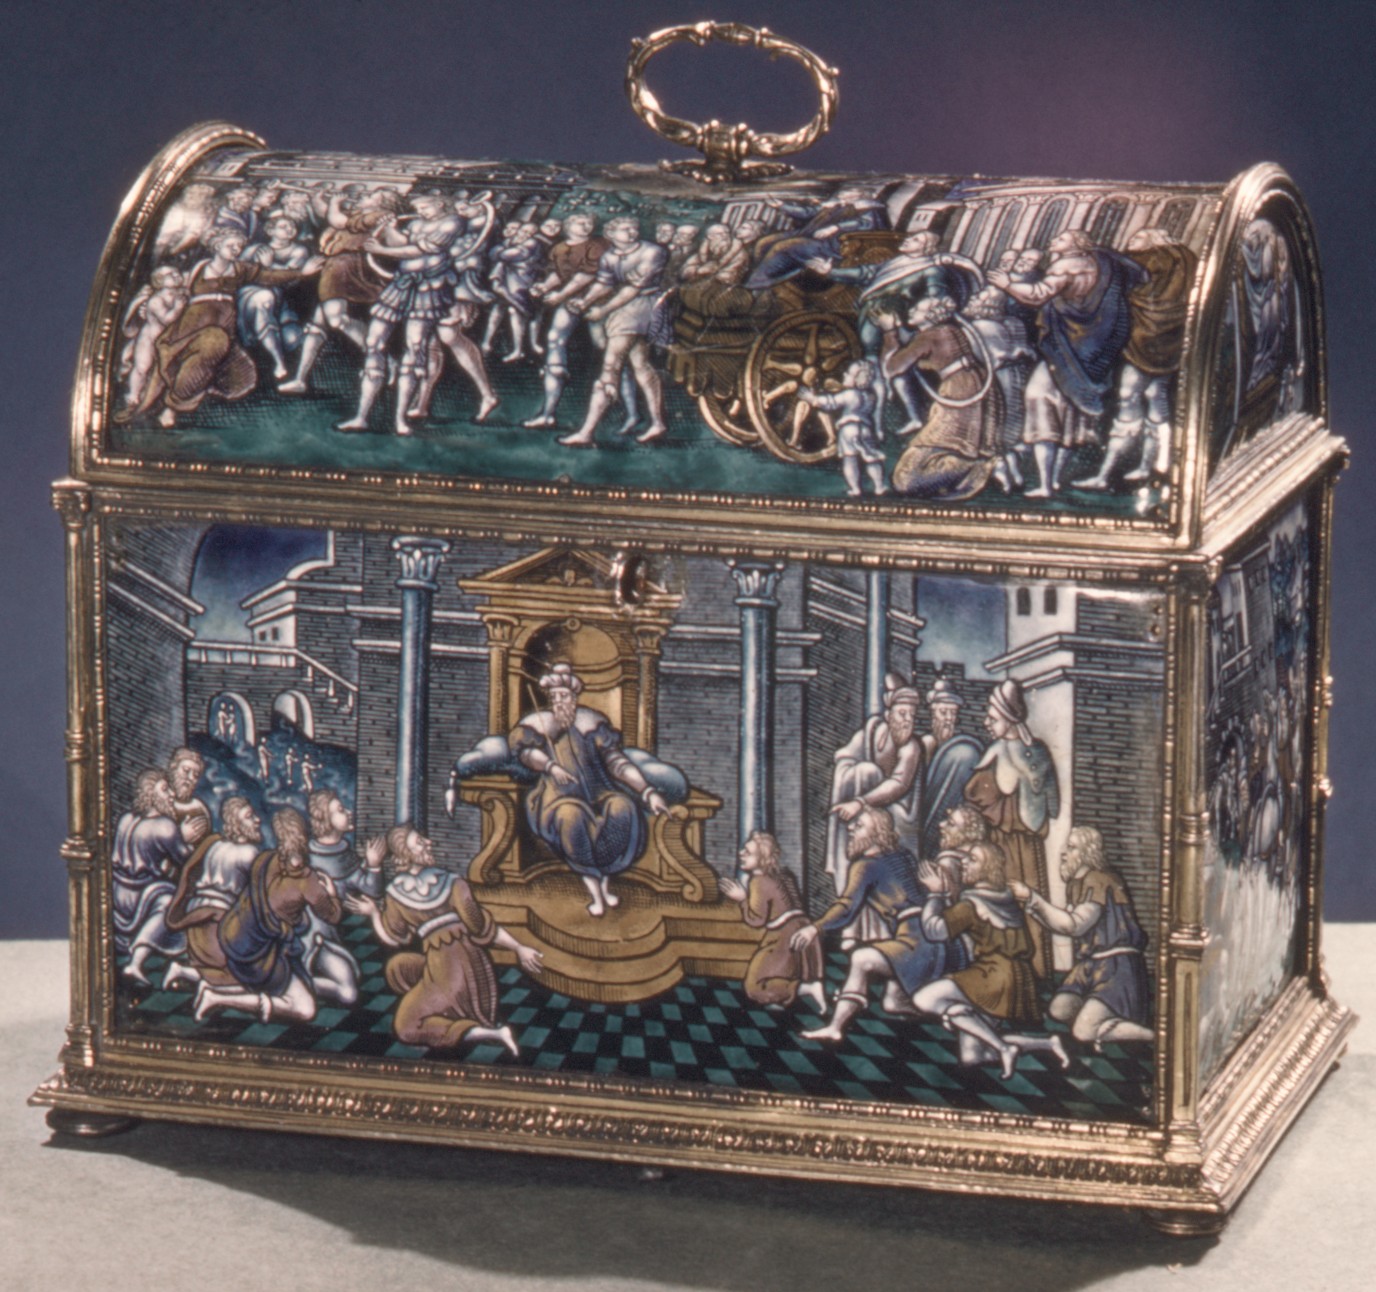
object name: casket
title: The Story of Joseph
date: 1851-1900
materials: copper, enamel, gilt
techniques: painting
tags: kings,men,women